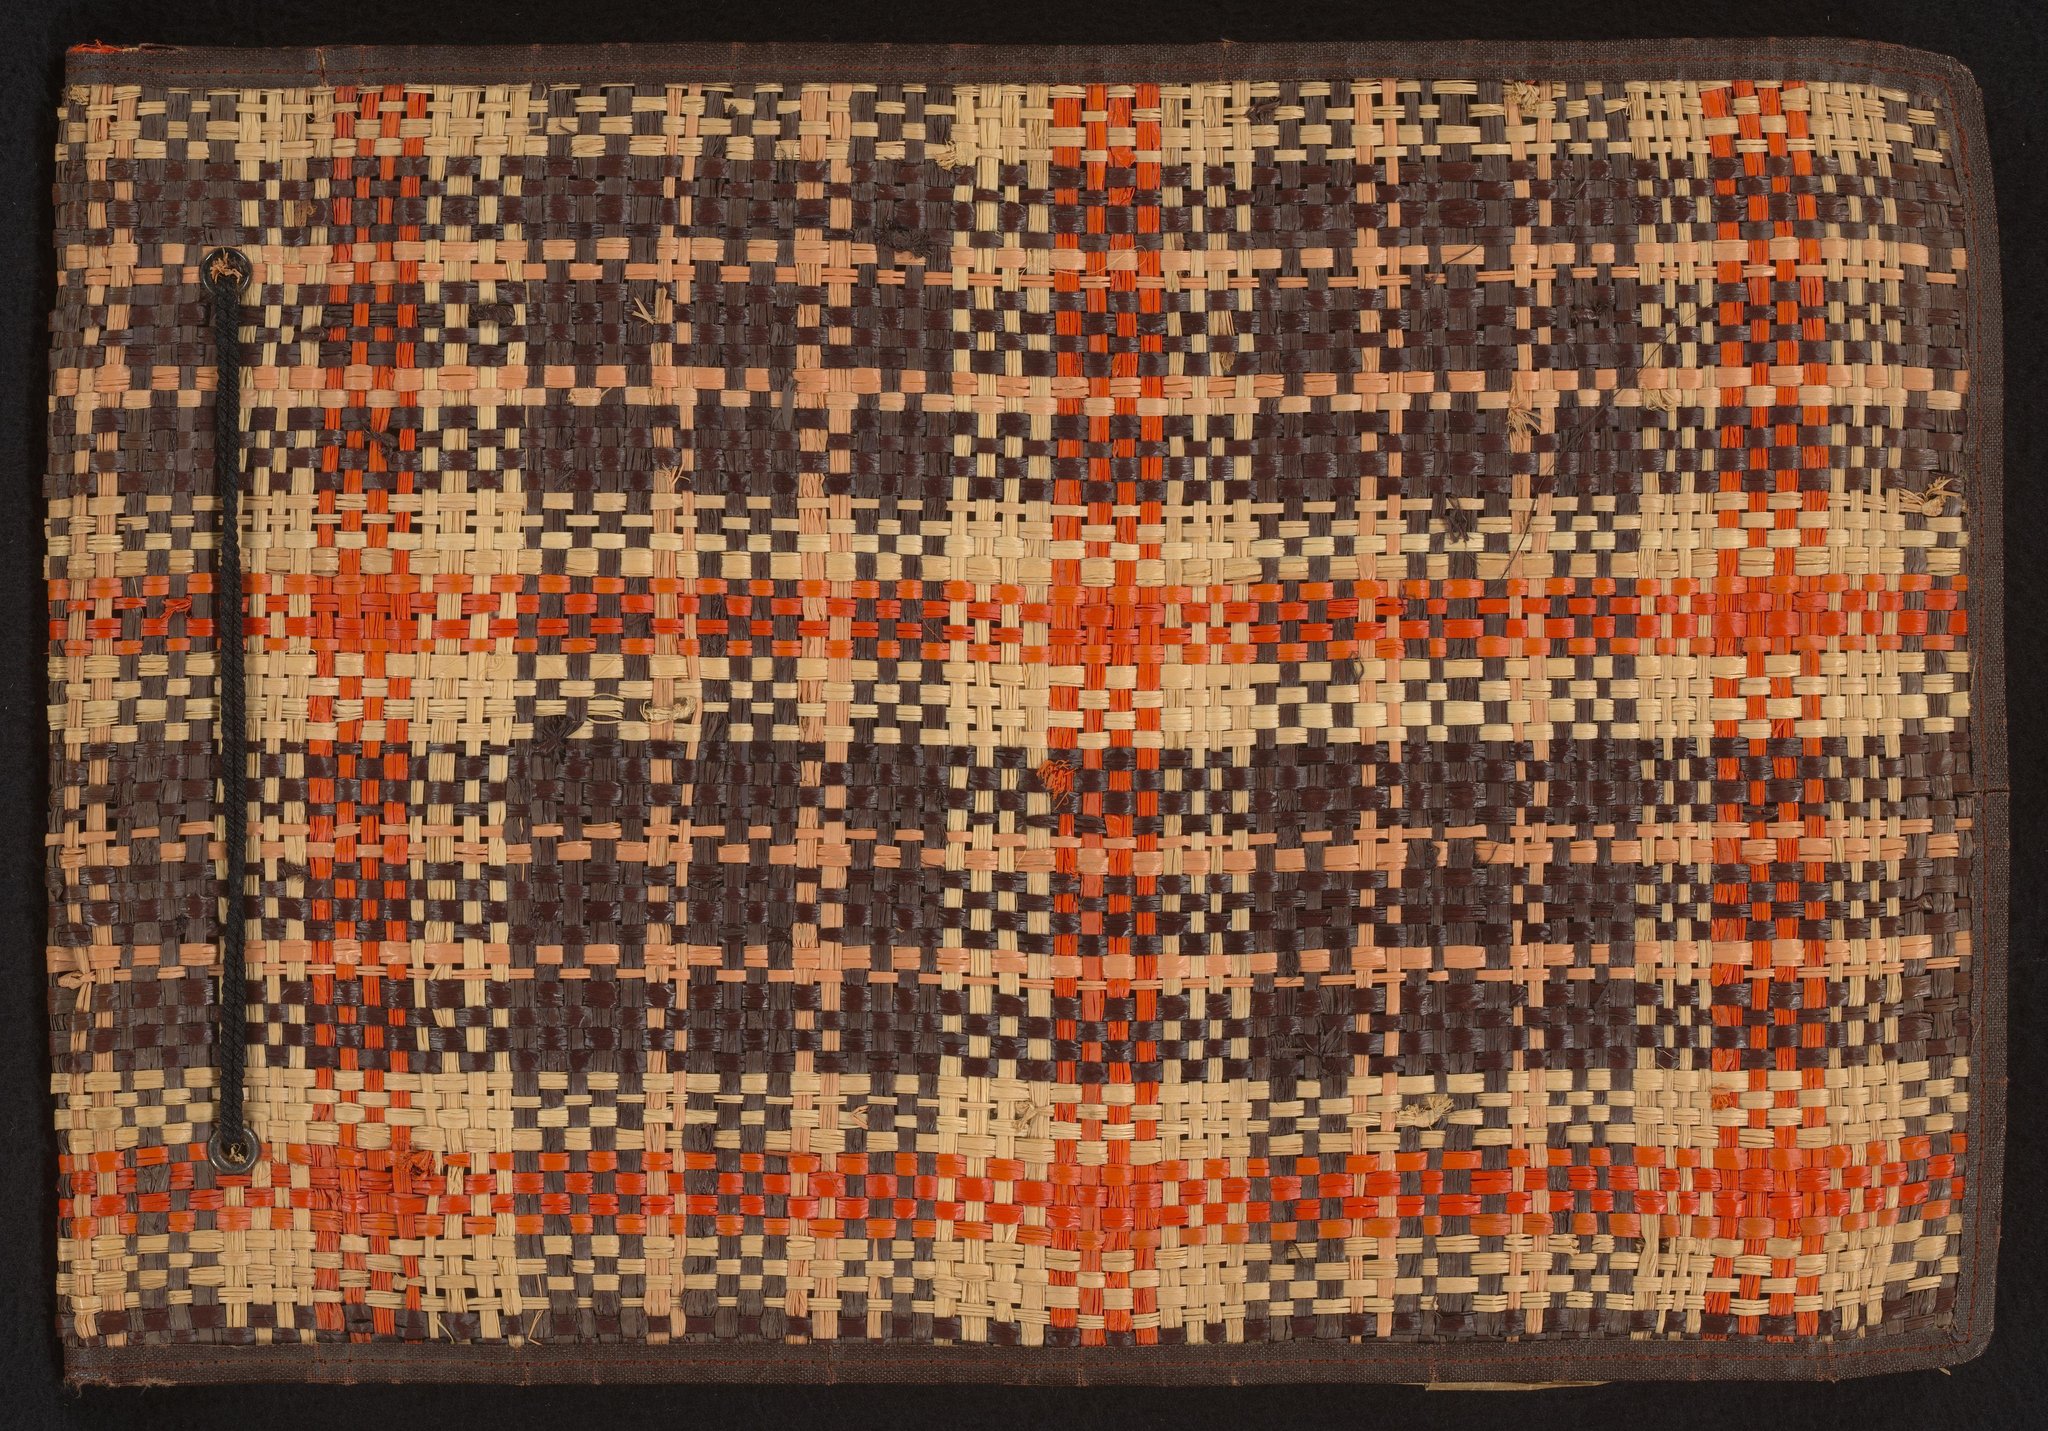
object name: slip in album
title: Familiealbum 1940-1947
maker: Anonymous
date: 1940-1947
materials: paper, photographic support, raffia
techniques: gelatin silver print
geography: the hague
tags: family life at home, the hague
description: Familiealbum uit de periode van de Tweede Wereldoorlog en enkele jaren daarna. Het album bevat 23 pagina's van bruin papier met in totaal 151 foto's. Een deel van de foto's ontbreekt. Tussen de pagina's beschermbladen van pergamijn. Achterin een losse foto in een melinex-mapje. De kaft bestaat uit gewoven raffia in beige, bruin en oranje. Het album behoorde toe aan Janny van der Meer (gehuwde naam). Tot de zomer van 1944 tonen de foto's familieuitstapjes en is de oorlog afwezig.